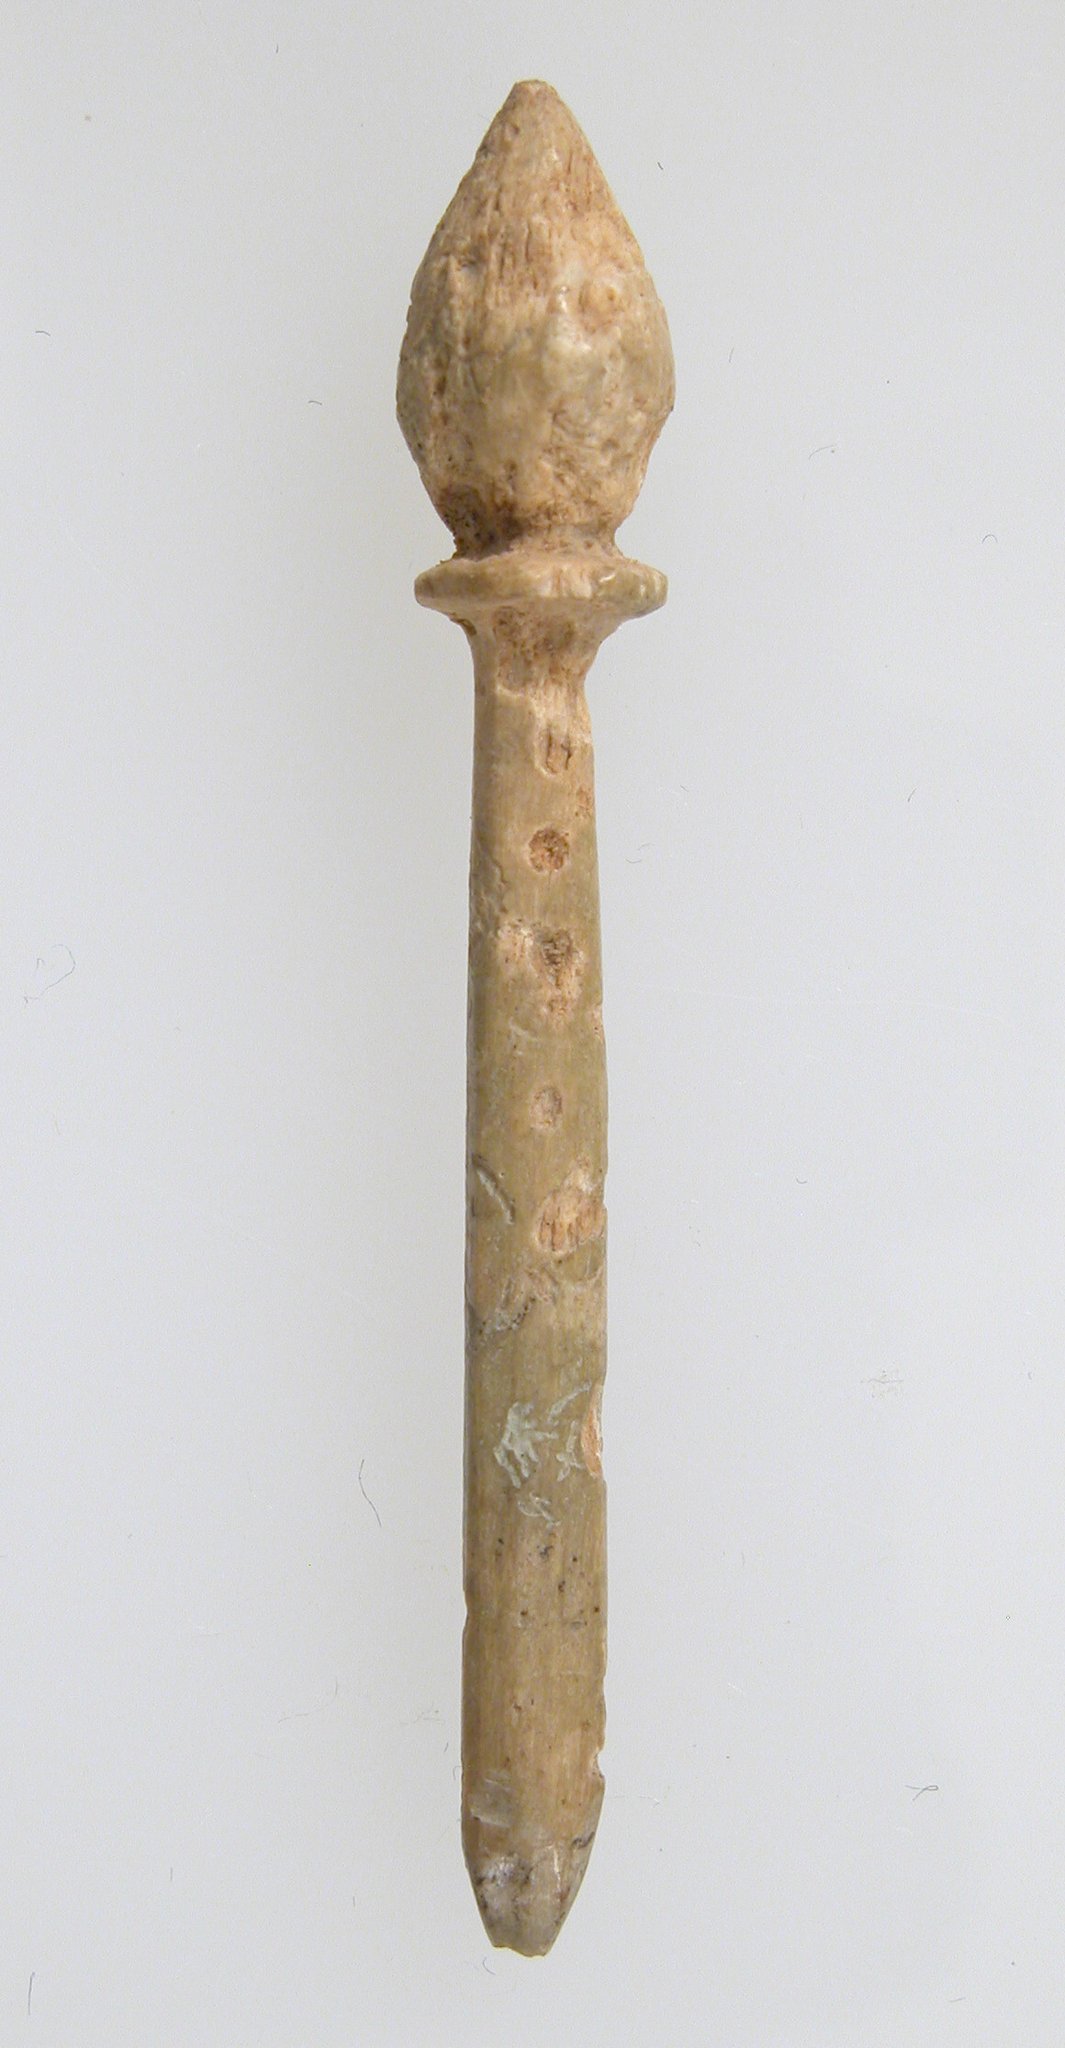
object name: hairpin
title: Upper Portion of Hairpin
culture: roman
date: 1-400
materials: bone